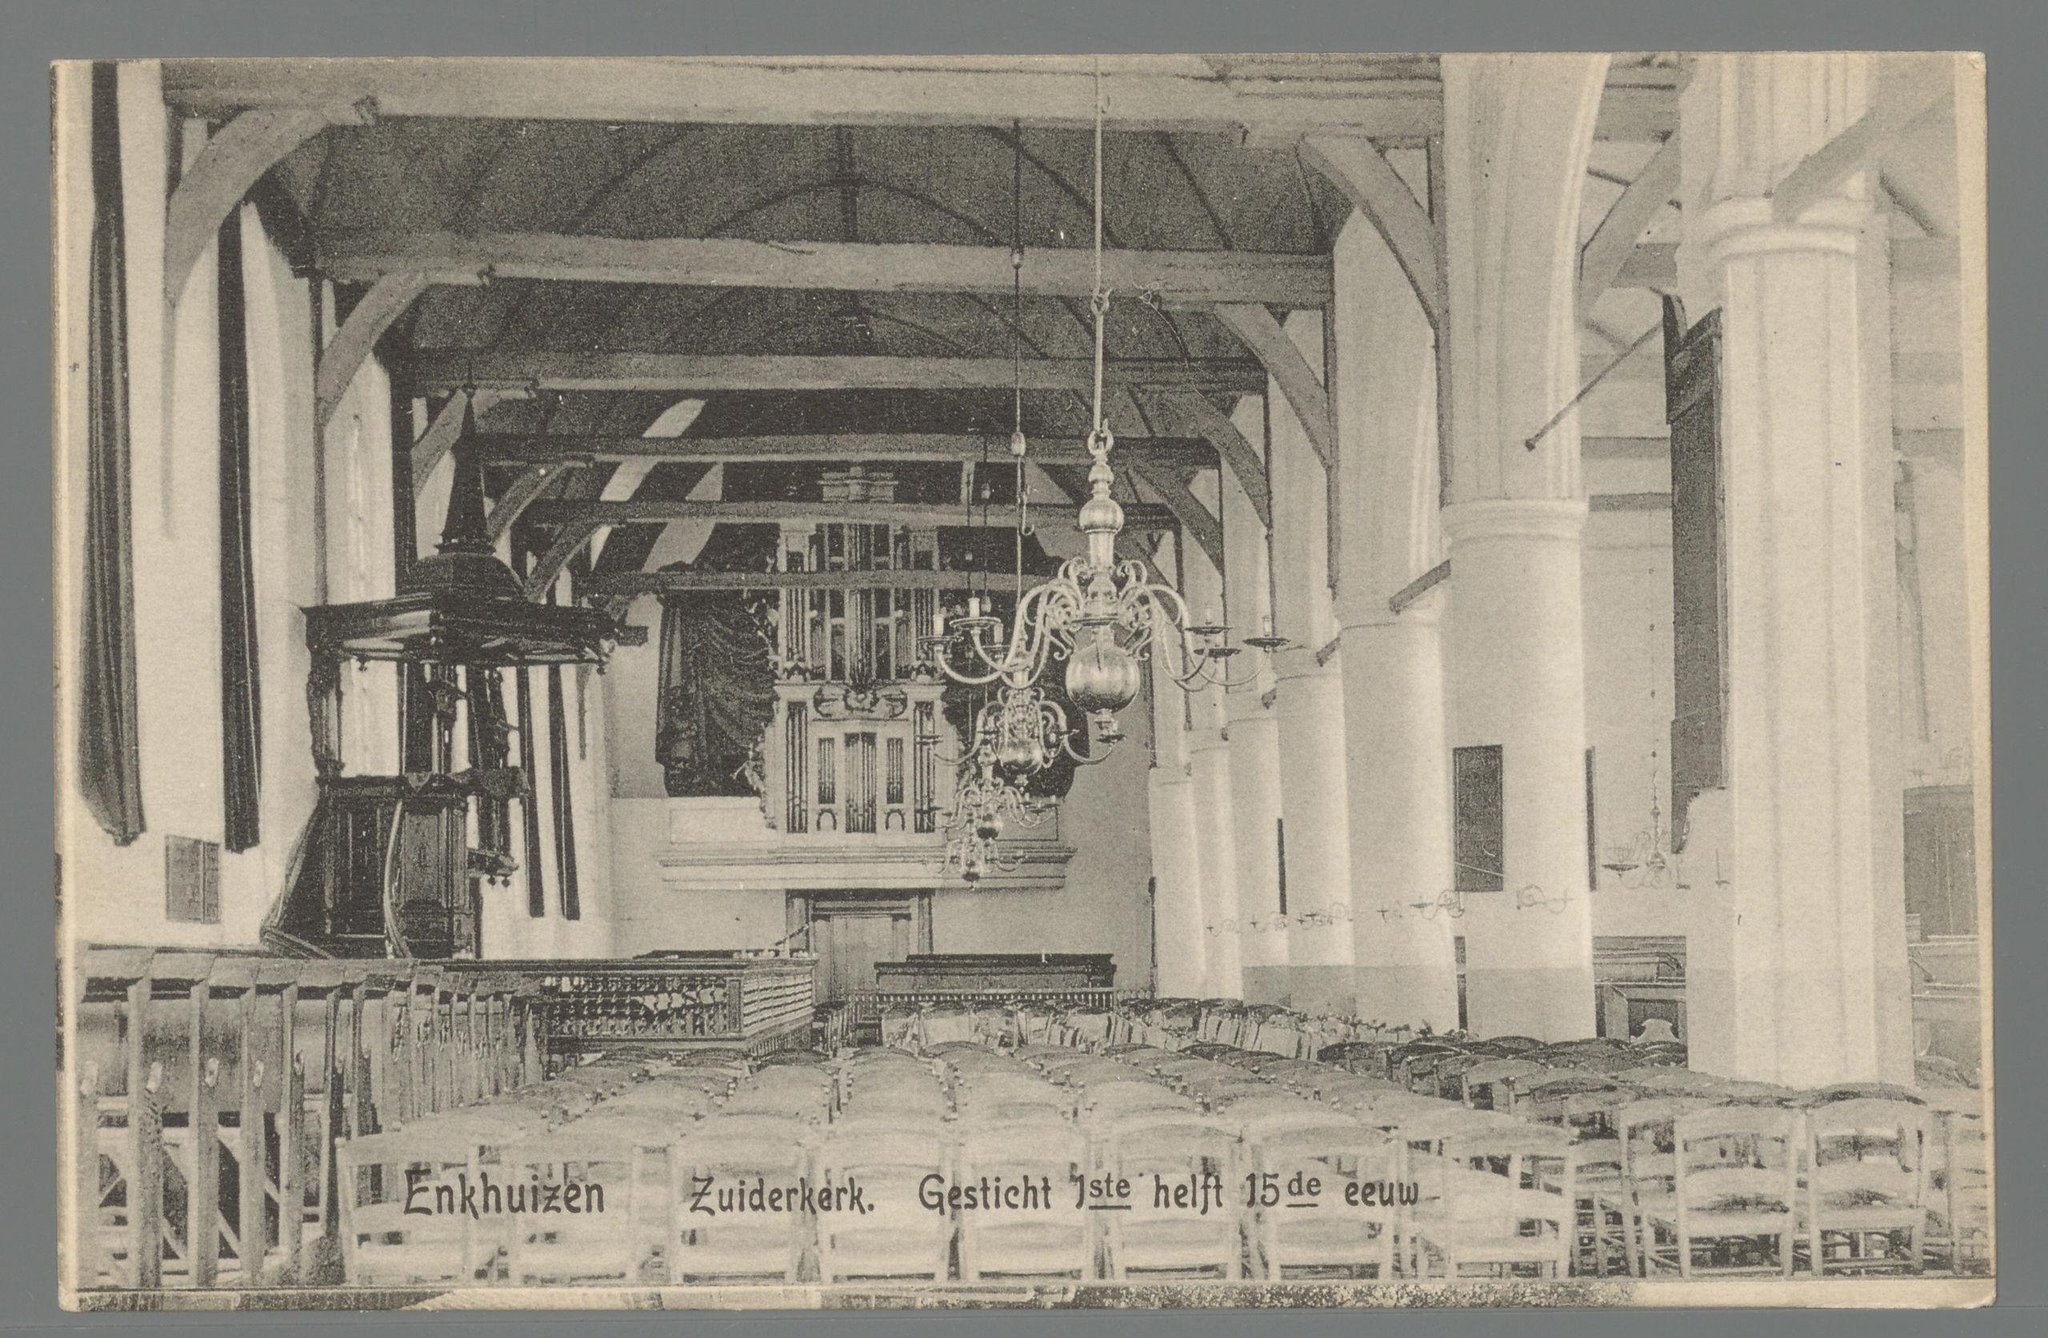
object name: ansichtkaart, prentbriefkaart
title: Enkhuizen Zuiderkerk. Gesticht 1ste helft 15de eeuw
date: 1906-1919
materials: cardboard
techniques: photograph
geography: haarlem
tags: church organ, interior of church, pulpit, ambo, chancel, enkhuizen